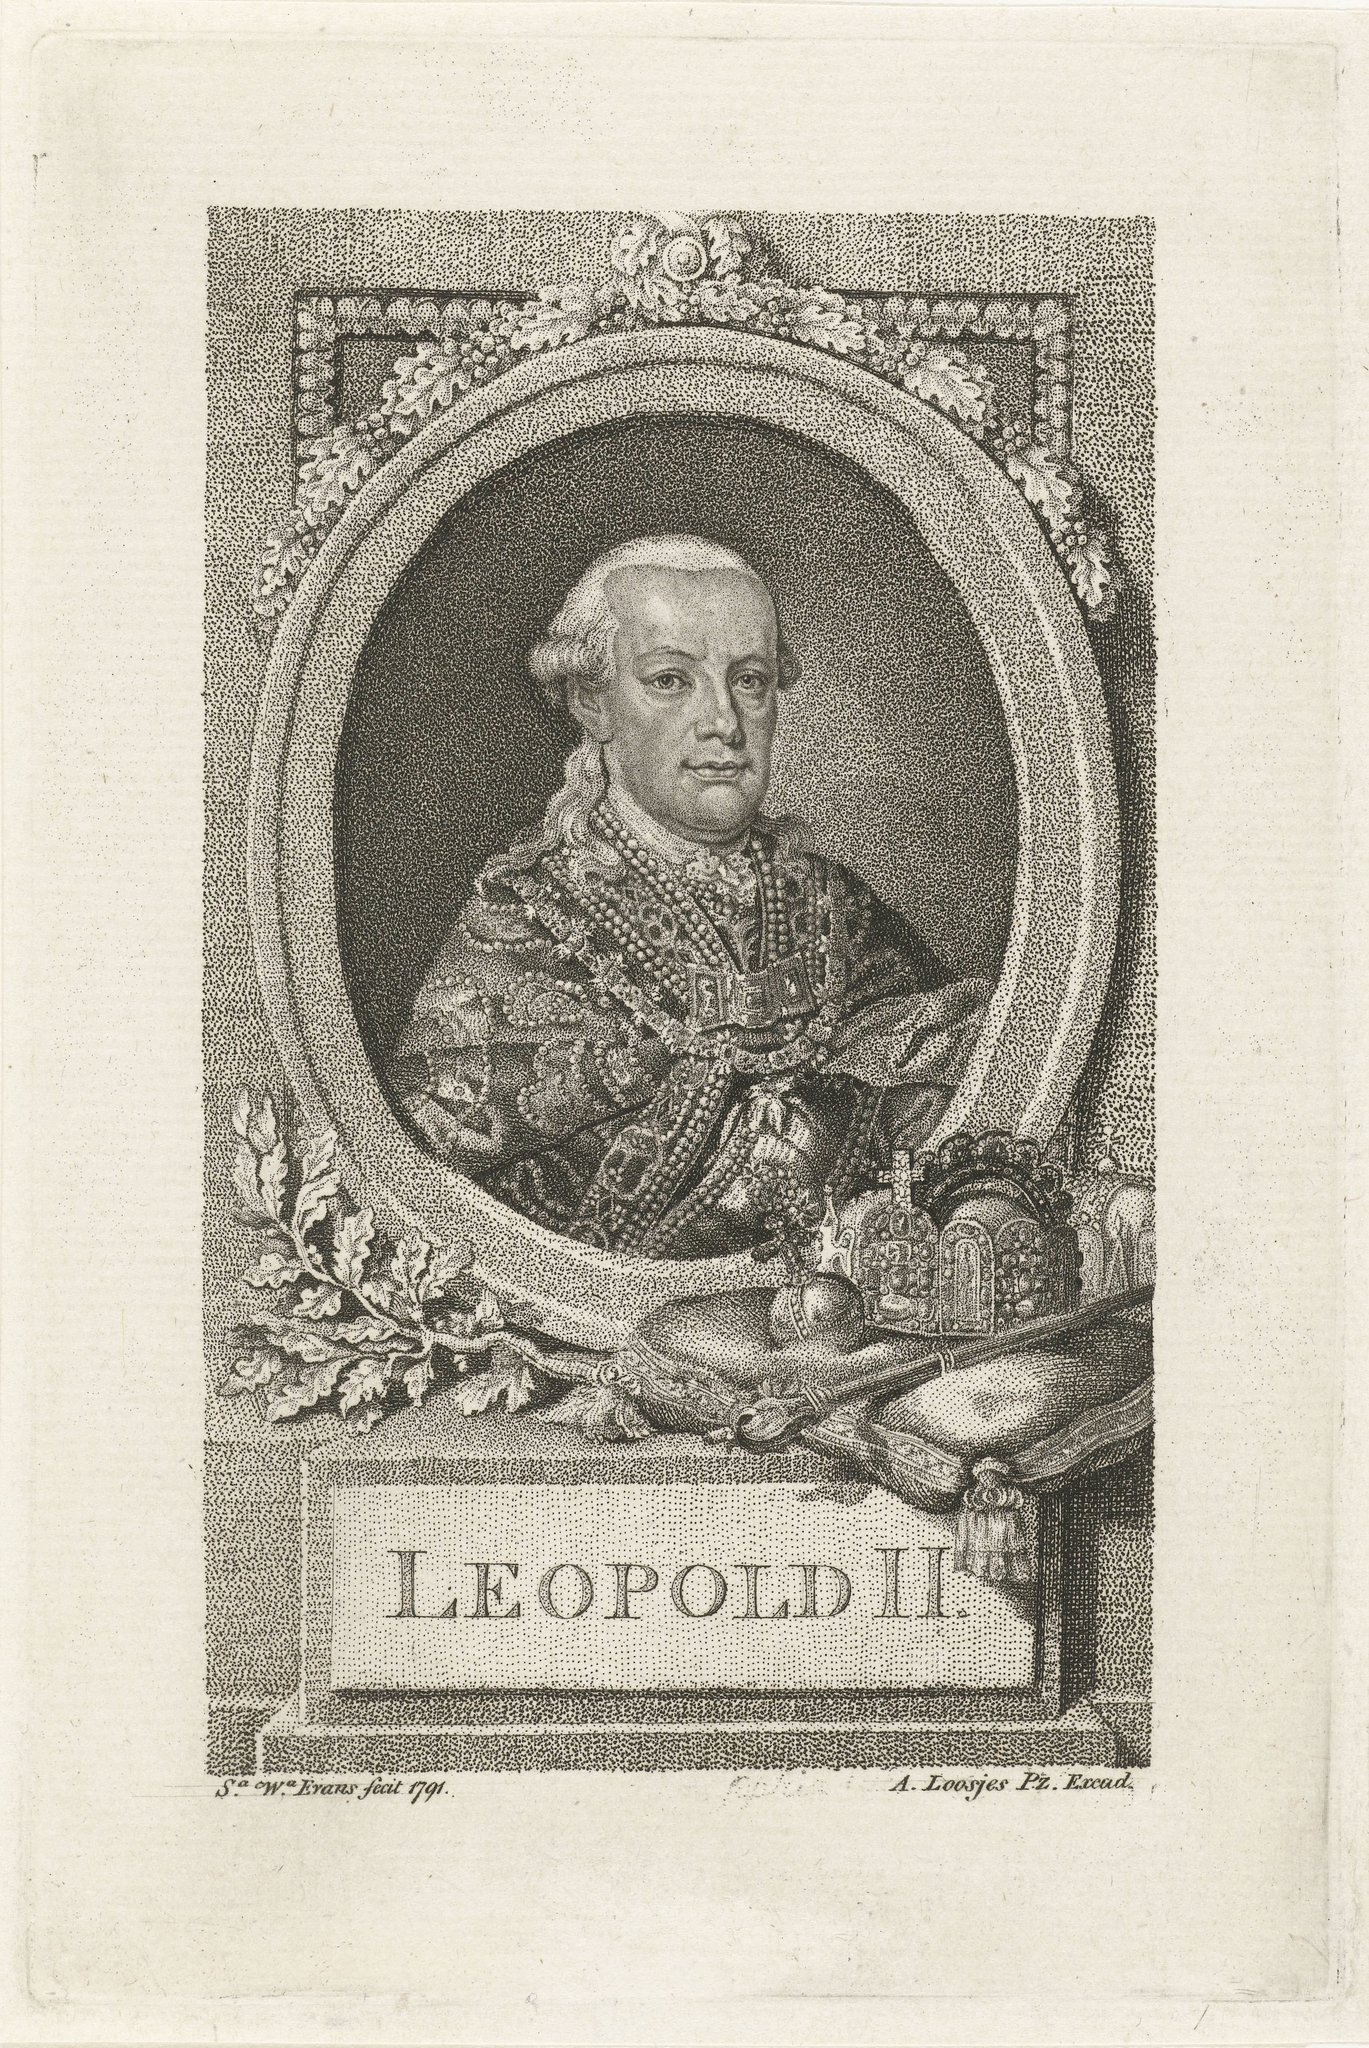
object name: print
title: Portret van Leopold II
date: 1791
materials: paper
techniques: stippled etching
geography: rotterdam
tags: leopold ii (keizer van oostenrijk)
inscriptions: collector's mark: Lugt 2228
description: Portret van Leopold II, aartshertog van Oostenrijk, groothertog van Toscane, vorst van de Zuidelijke Nederlanden, koning van Bohemen en keizer van het Heilige Roomse Rijk. Afgebeeld in ovale omlijsting met versiering van eikenblad. Op de console een kroon, scepter en rijksappel.